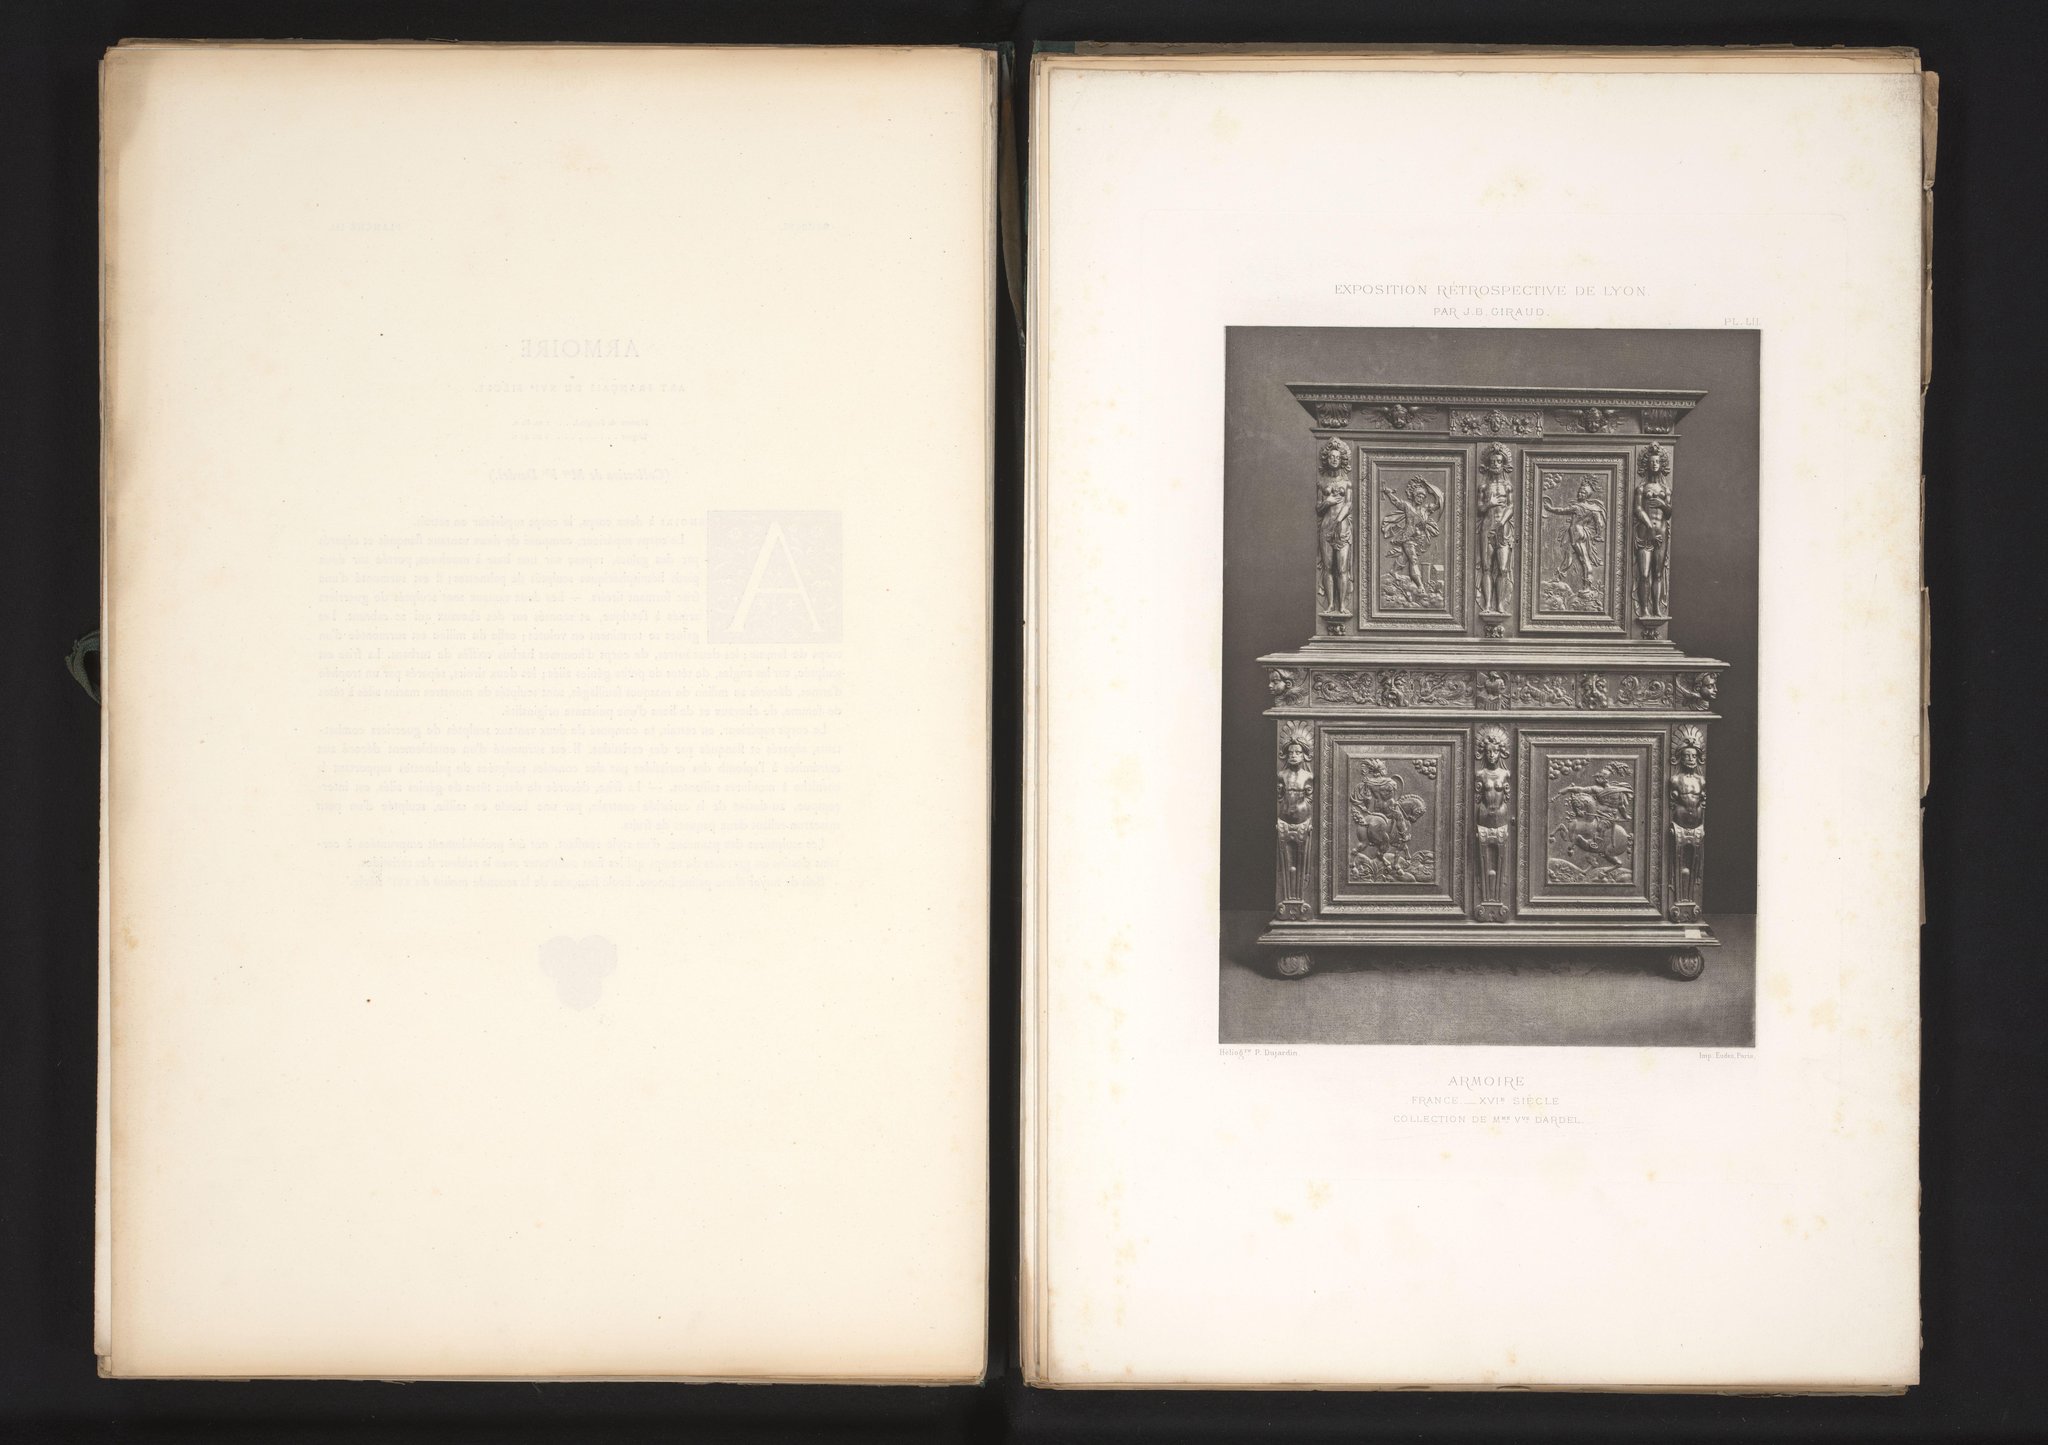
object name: photomechanical print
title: 16de-eeuwse Franse kast van hout, op de Exposition Rétrospective van 1877 in Lyon, Frankrijk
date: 1877-1878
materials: paper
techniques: photoaquatint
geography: paris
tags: ornamental cupboard (+ wood and other phytogenic material), lyon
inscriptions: inscription: ‘EXPOSITION RÉTROSPECTIVE DE LYON/ PAR J. B. GIRAUD.’, inscription: ‘ARMOIRE/ FRANCE_XVIe SIÈCLE/ COLLECTION DE Mme Vve DARDEL.’, number: ‘PL. LII.’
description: Deze prent maakt deel uit van een omslag met 79 prenten op 54 bladen en 65 tekstbladen.